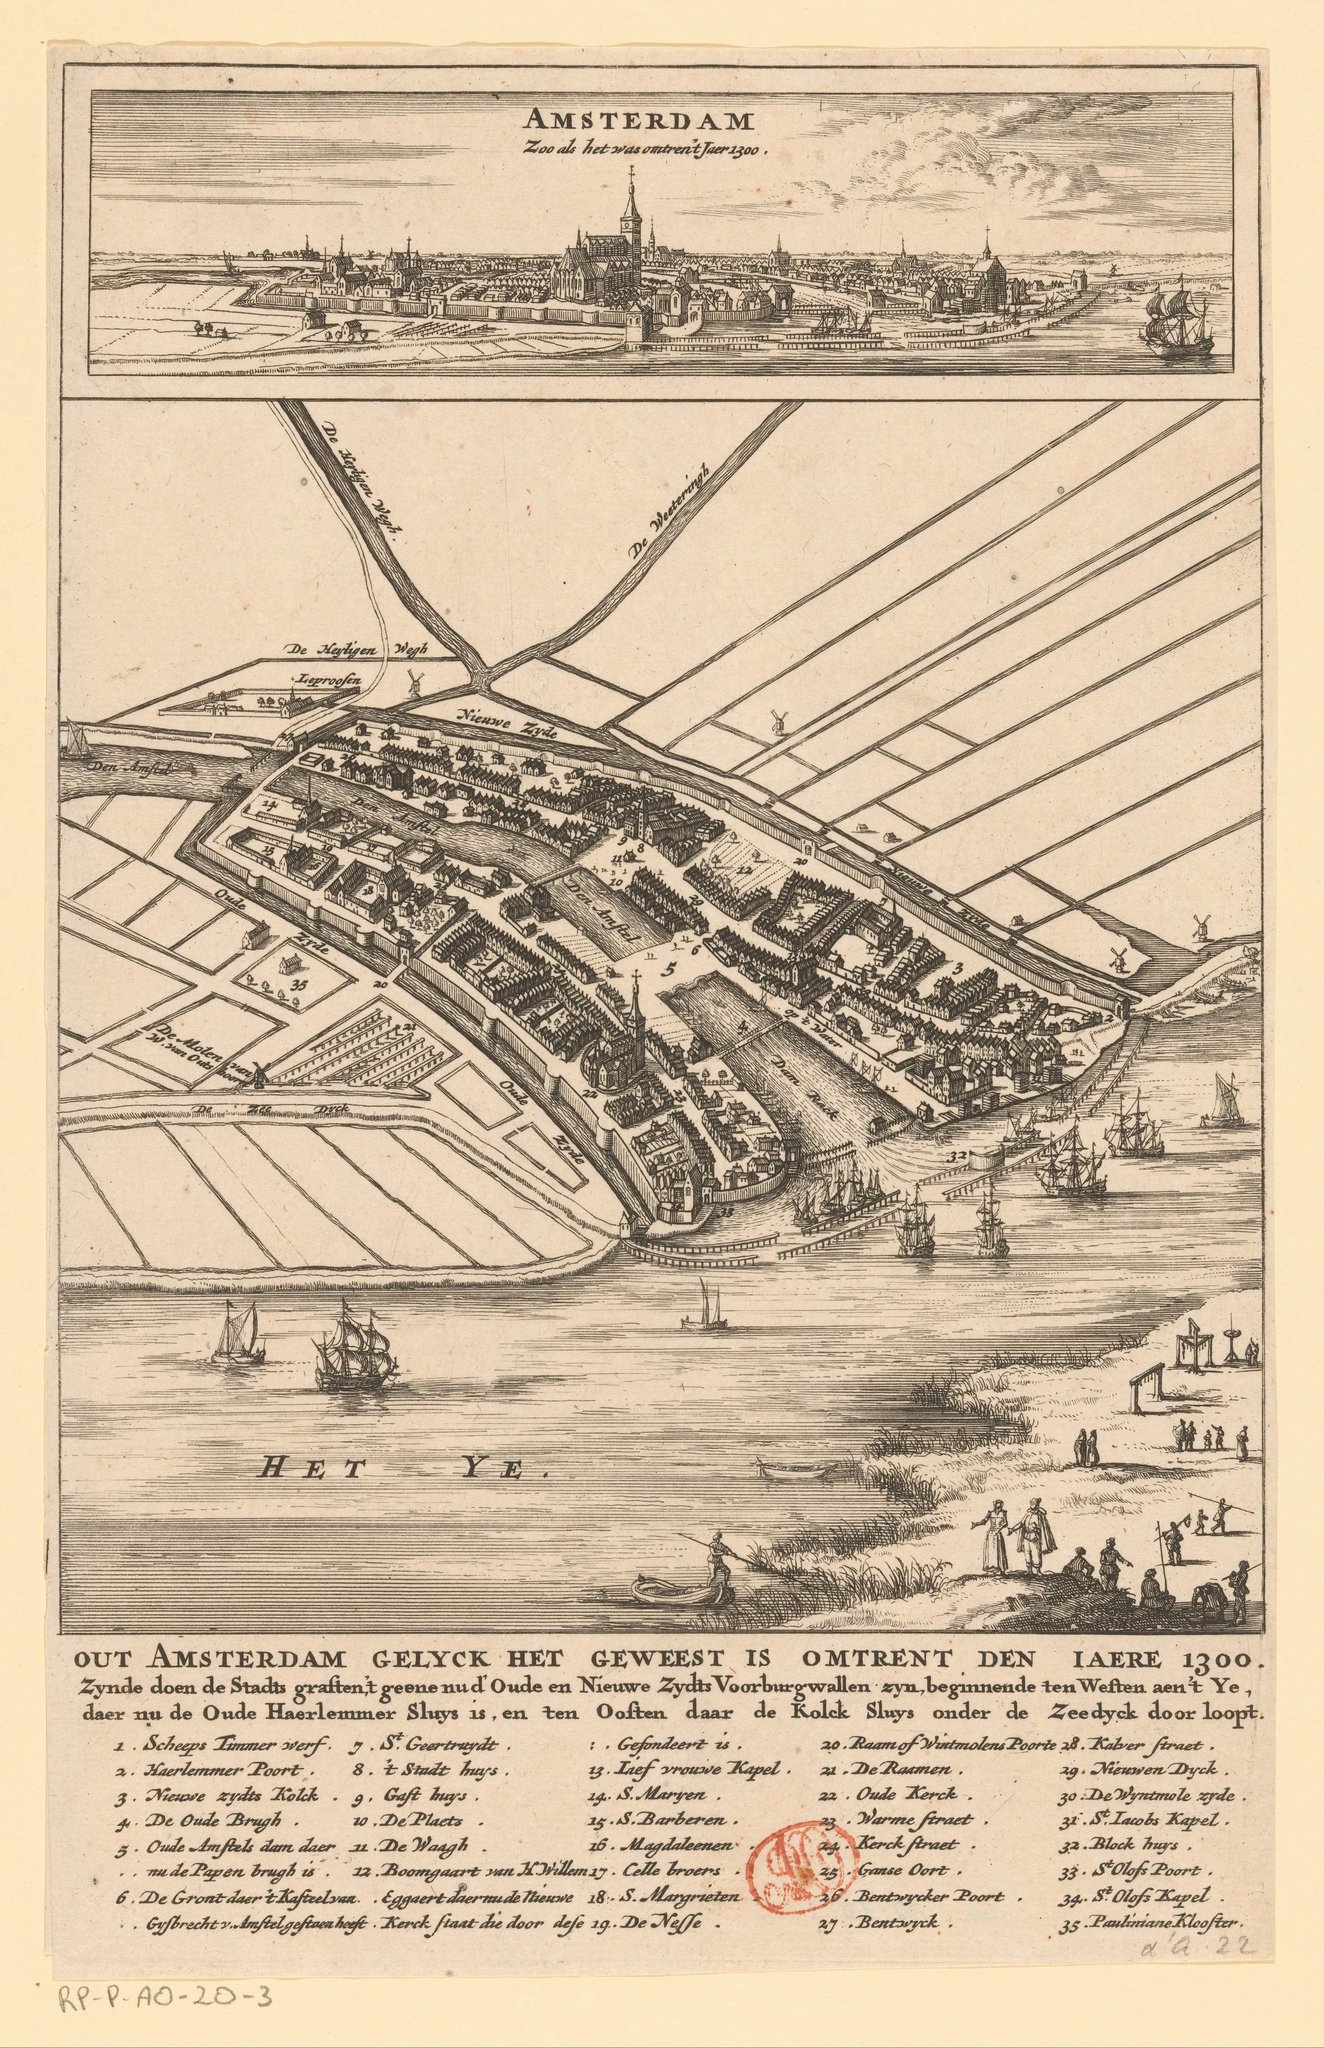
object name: print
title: Out Amsterdam gelyck het geweest is omtrent den iaere 1300 / Amsterdam Zoo als het was omtren 't Jaer 1300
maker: jan luyken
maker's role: draughtsman, print maker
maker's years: 1649-1712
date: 1693-1694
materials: paper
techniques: engraving, etching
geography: amsterdam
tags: maps of cities, prospect of city, town panorama, silhouette of city, amsterdam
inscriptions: collector's mark: Lugt 195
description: Huidige staat van prent ook gebruikt in: Commelin, Caspar. Beschryvinge van Amsterdam, desselfs eerste oorspronk uyt den Huyse (…). 2 delen. Amsterdam: Abraham Wolfgang, Gillis Janssonius van Waesberge, Johannes Janssonius van Waesberge II, weduwe Dirk Boom I, Hendrick Boom en Rembertus Goethals, 1693, dl. 1. En in: Commelin, Caspar. Beschryvinge van Amsterdam, zynde een naukeurige verhandelinge van desselfs eerste oorspronk uyt (…). 2 delen. Amsterdam: weduwe Aart Dircksz Oossaan, 1694, dl. 1.